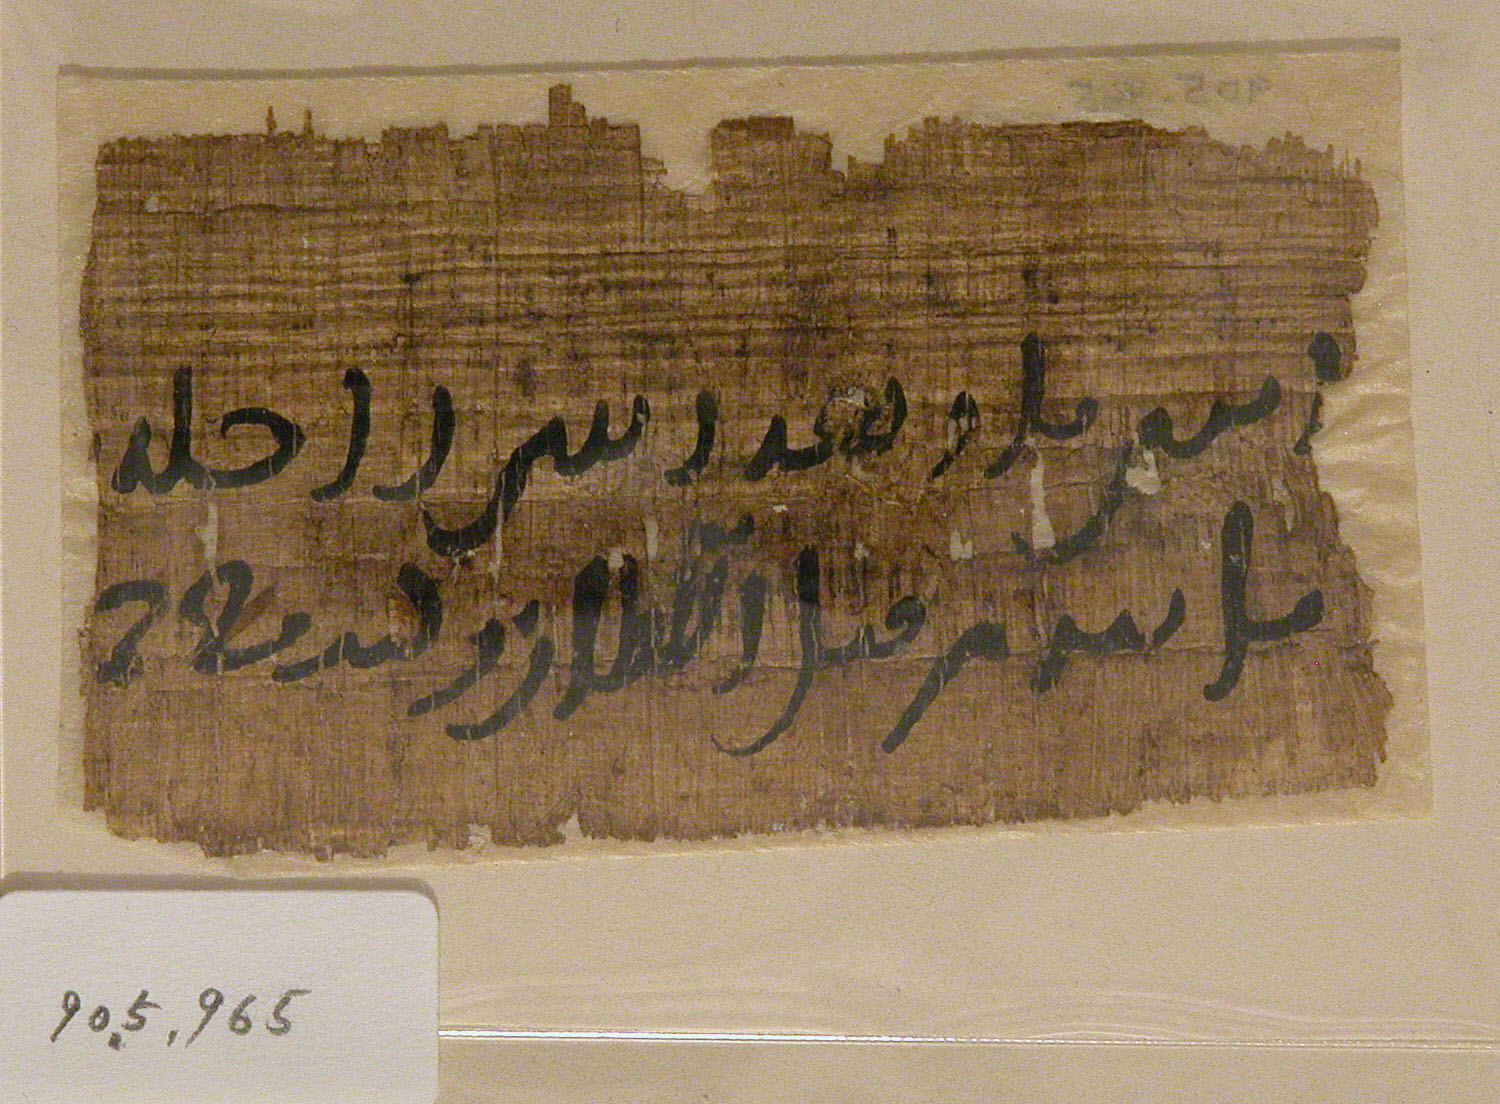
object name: non illustrated single work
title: Letter Fragment on Papyrus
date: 601-900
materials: ink, papyrus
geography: egypt